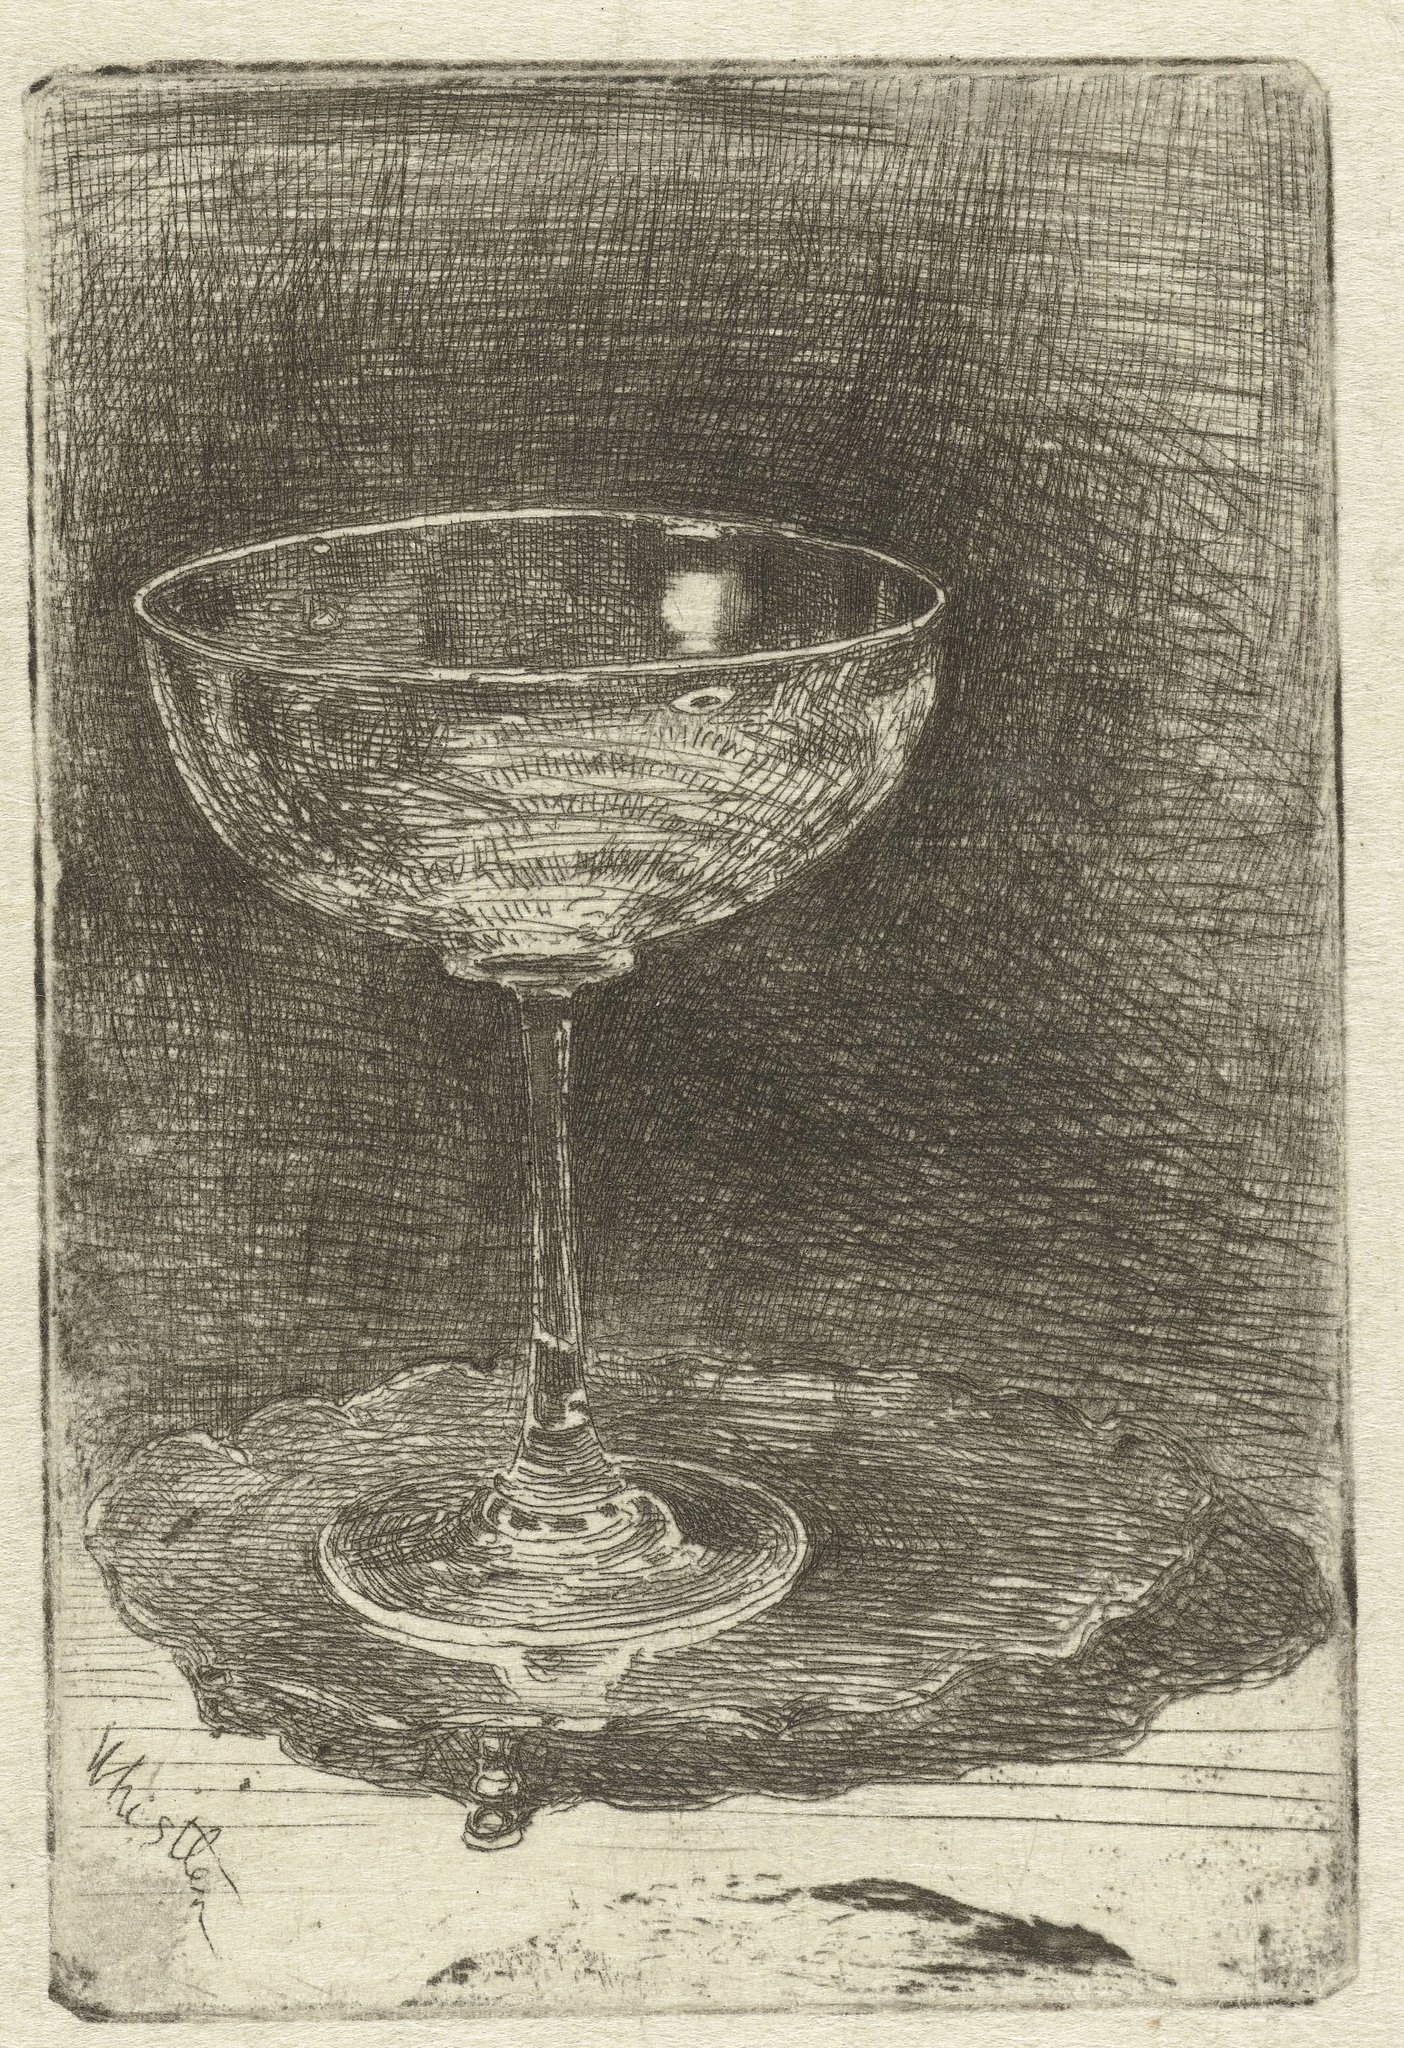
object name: print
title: The Wine-Glass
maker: james abbott mcneill whistler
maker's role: painter, print maker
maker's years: 1834-1903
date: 1858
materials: paper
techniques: etching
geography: england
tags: glass, rummer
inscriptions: collector's mark: Lugt 2166, collector's mark: Lugt 2760